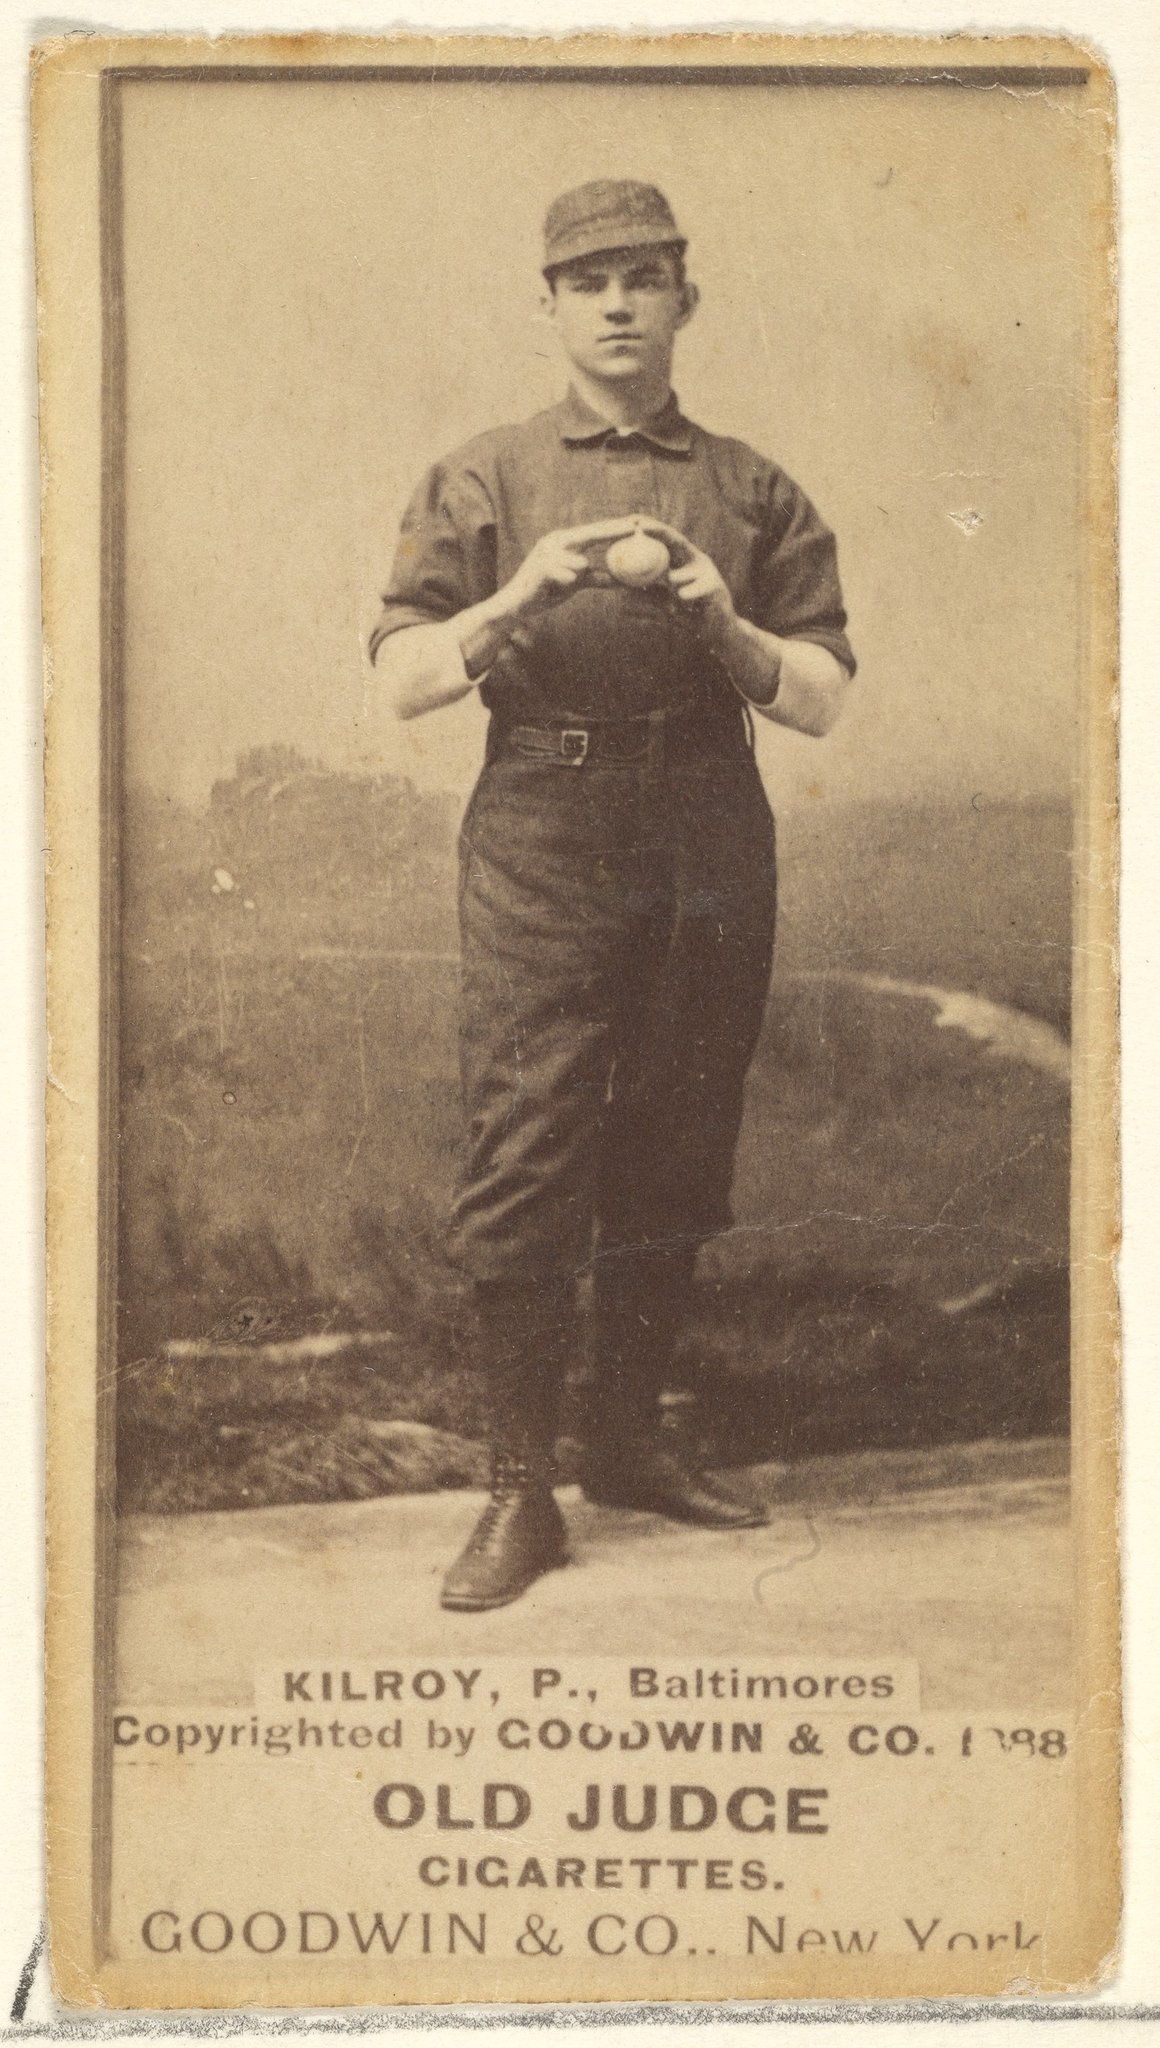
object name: baseball card, photograph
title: Kilroy, Pitcher, Baltimore Orioles, from the Old Judge series (N172) for Old Judge Cigarettes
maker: goodwin & company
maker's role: publisher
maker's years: 1850-1950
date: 1888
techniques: albumen silver print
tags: men,portraits,baseball,athletes